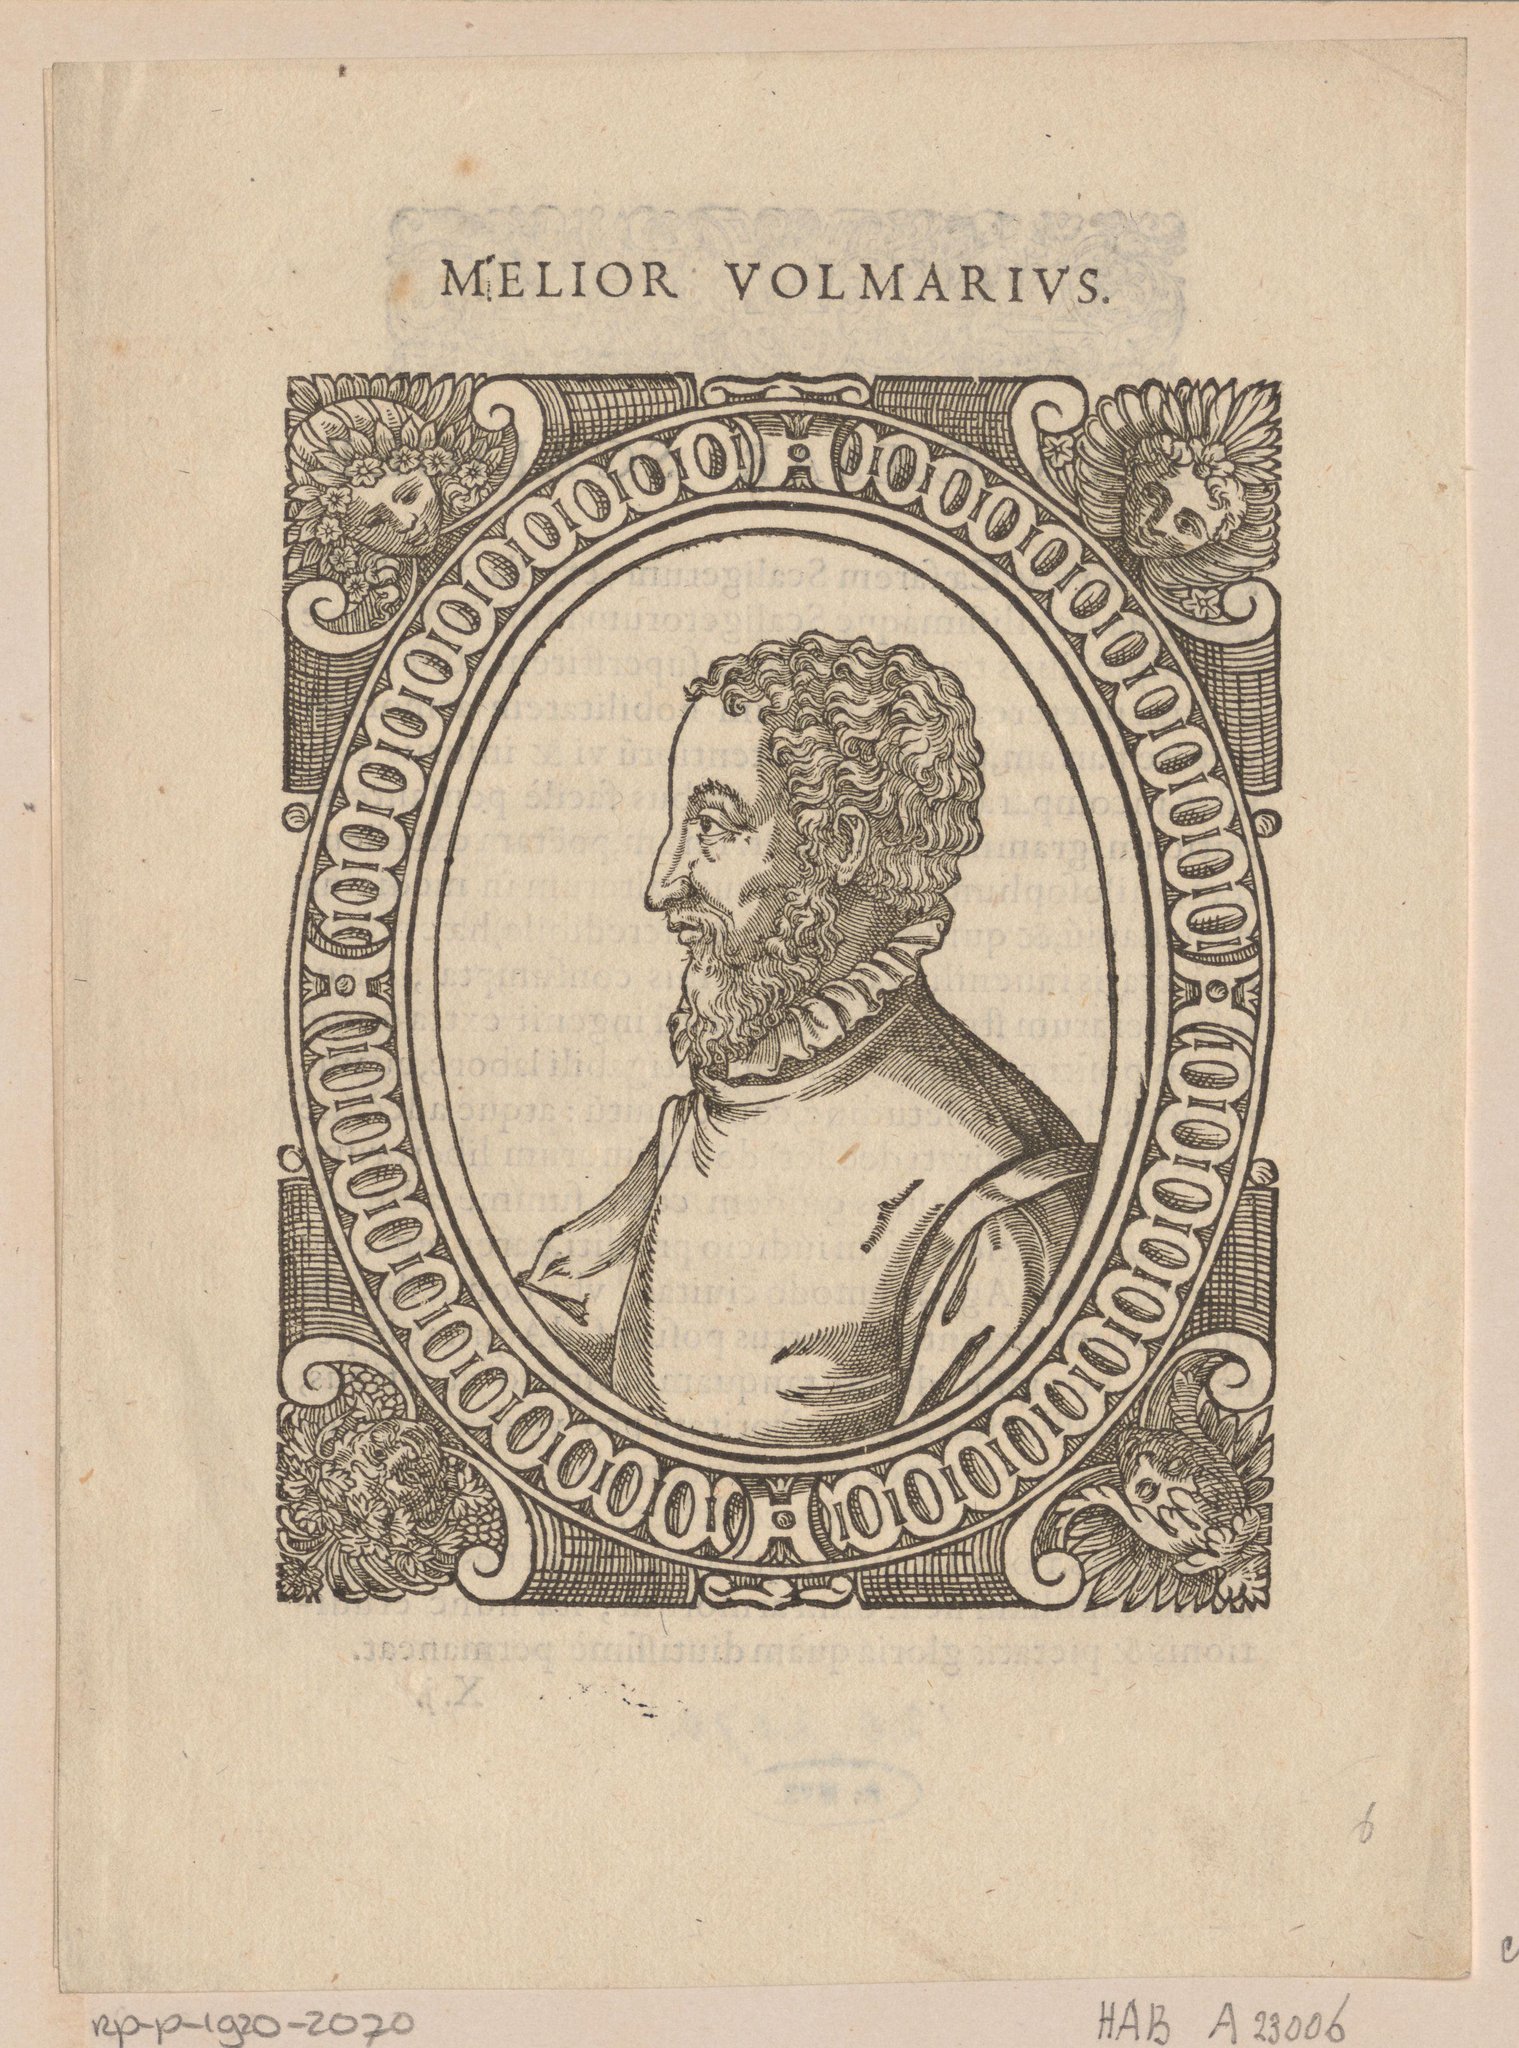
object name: print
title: Portret van Melchior Rufus Volmar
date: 1581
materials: paper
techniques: letterpress printing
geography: geneva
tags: germany, scholar, philosopher, historical persons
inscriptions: collector's mark: Lugt 2228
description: Prent uit: Beze, Theodore de. Les vrais pourtraits des hommes illustres en piete et doctrine (...). Genève: Jean de Laon, 1581.